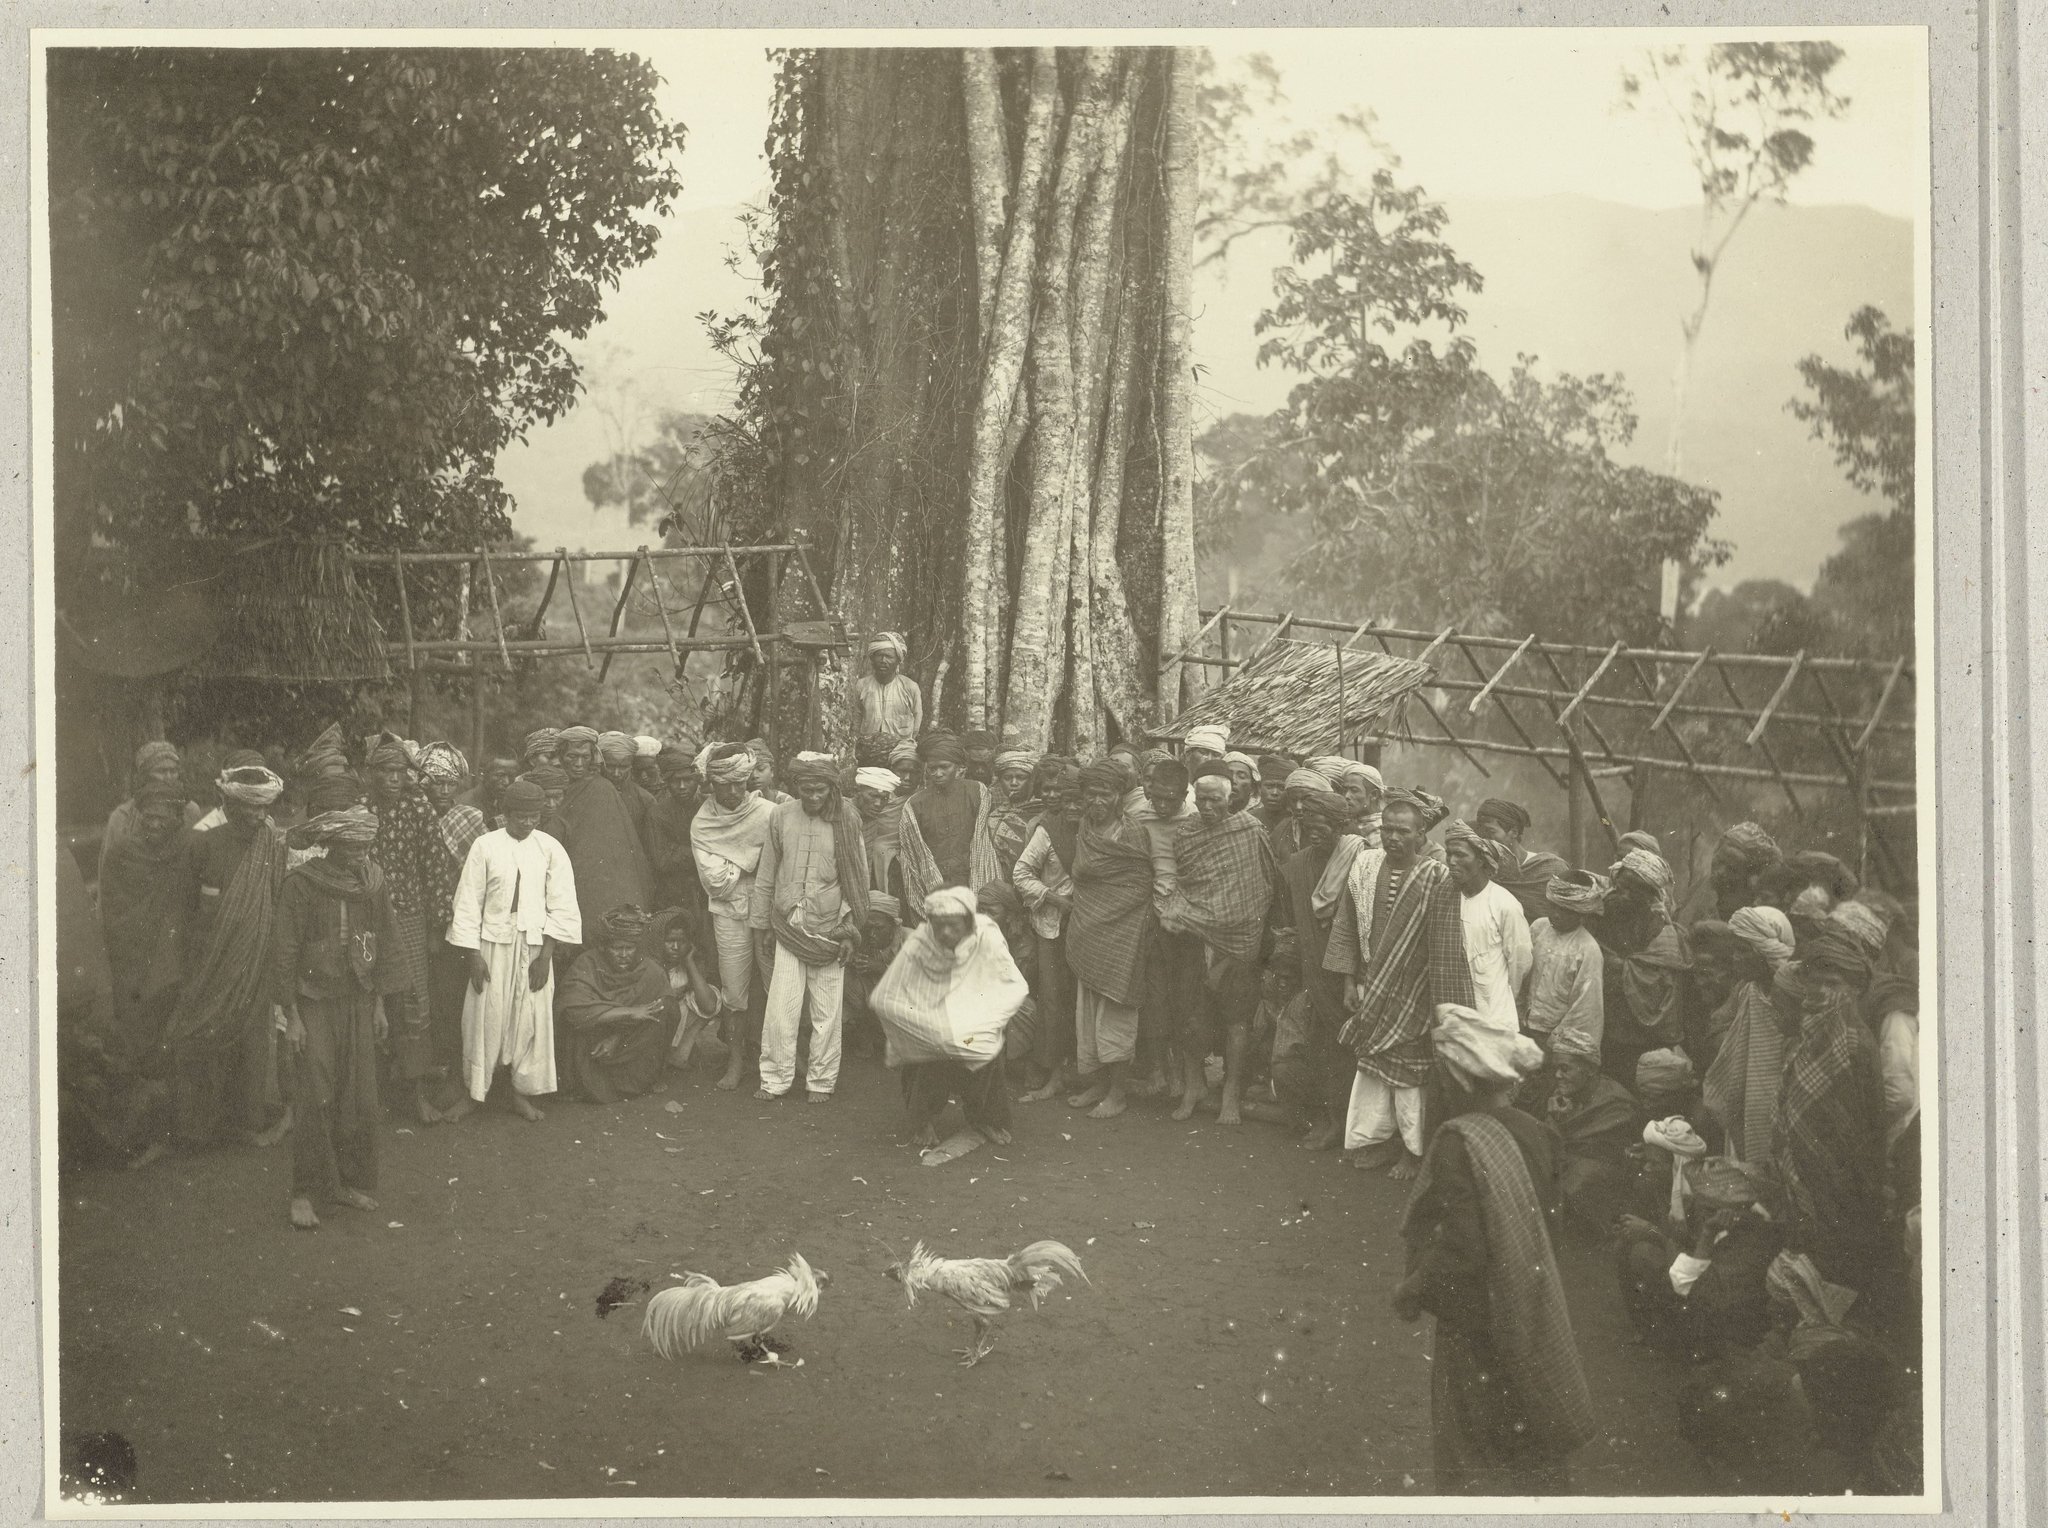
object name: photograph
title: Twee vechthanen in een arena met publiek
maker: christiaan benjamin nieuwenhuis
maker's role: publisher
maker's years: 1863-1922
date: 1891-1912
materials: paper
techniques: gelatin silver print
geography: medan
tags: cock-fighting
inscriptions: inscription: ‘Vechthanen Pad: Bovenlanden.’